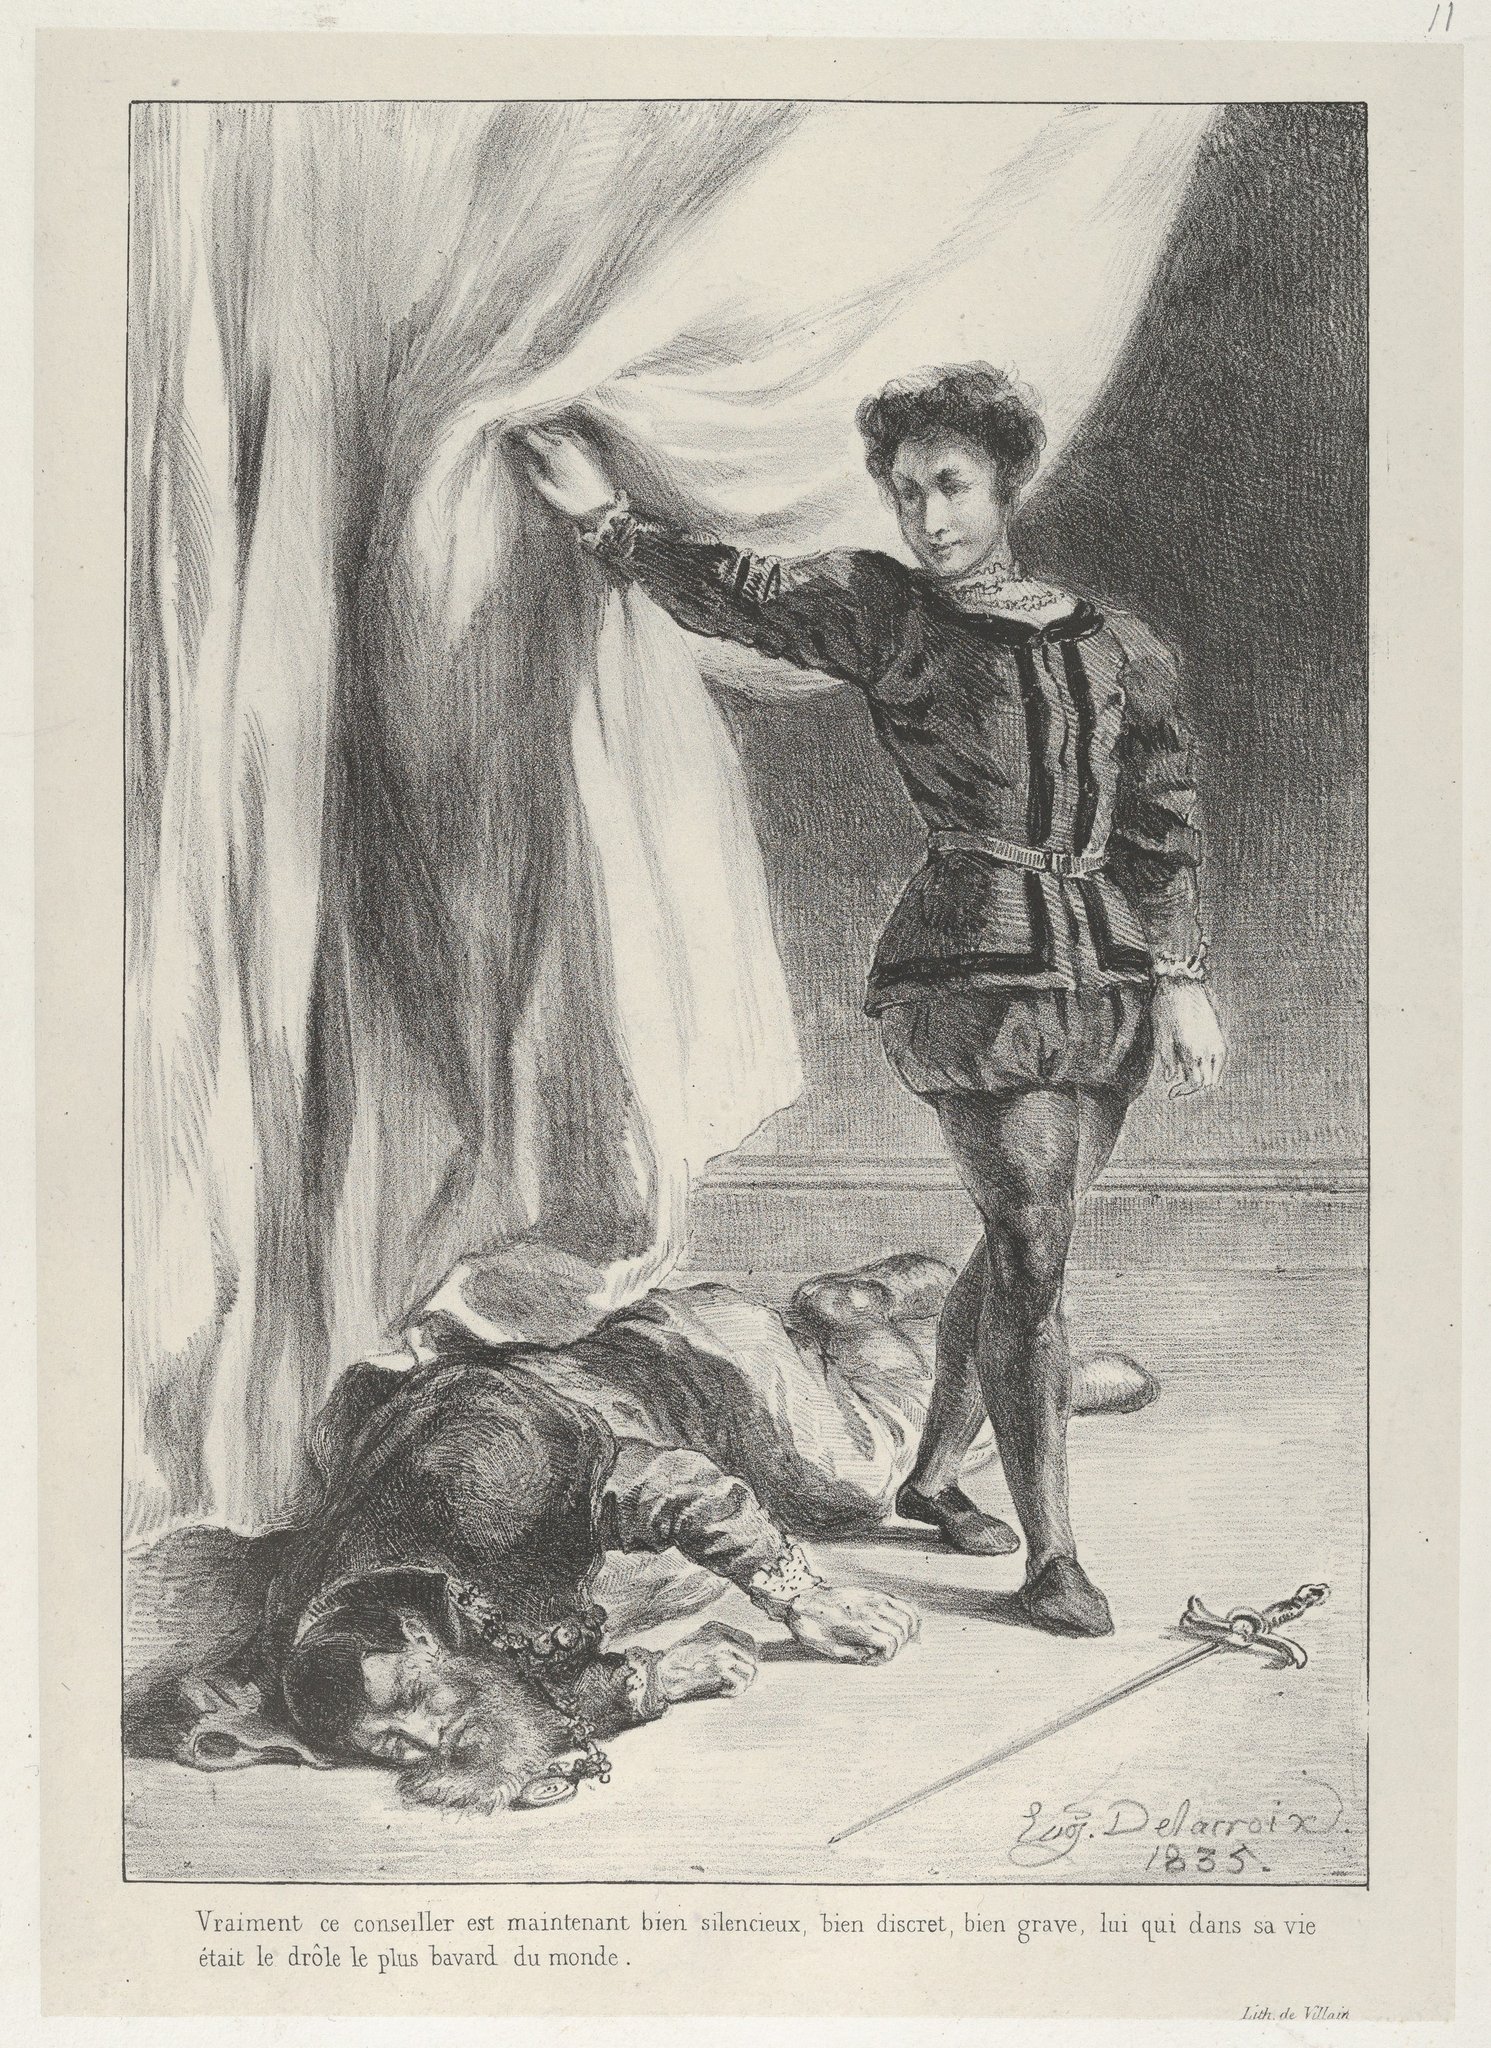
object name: print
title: Hamlet and the Corpse of Polonius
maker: eugène delacroix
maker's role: artist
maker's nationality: french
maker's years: 1798-1863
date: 1835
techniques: lithograph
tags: swords,shakespeare,corpses,men,hamlet